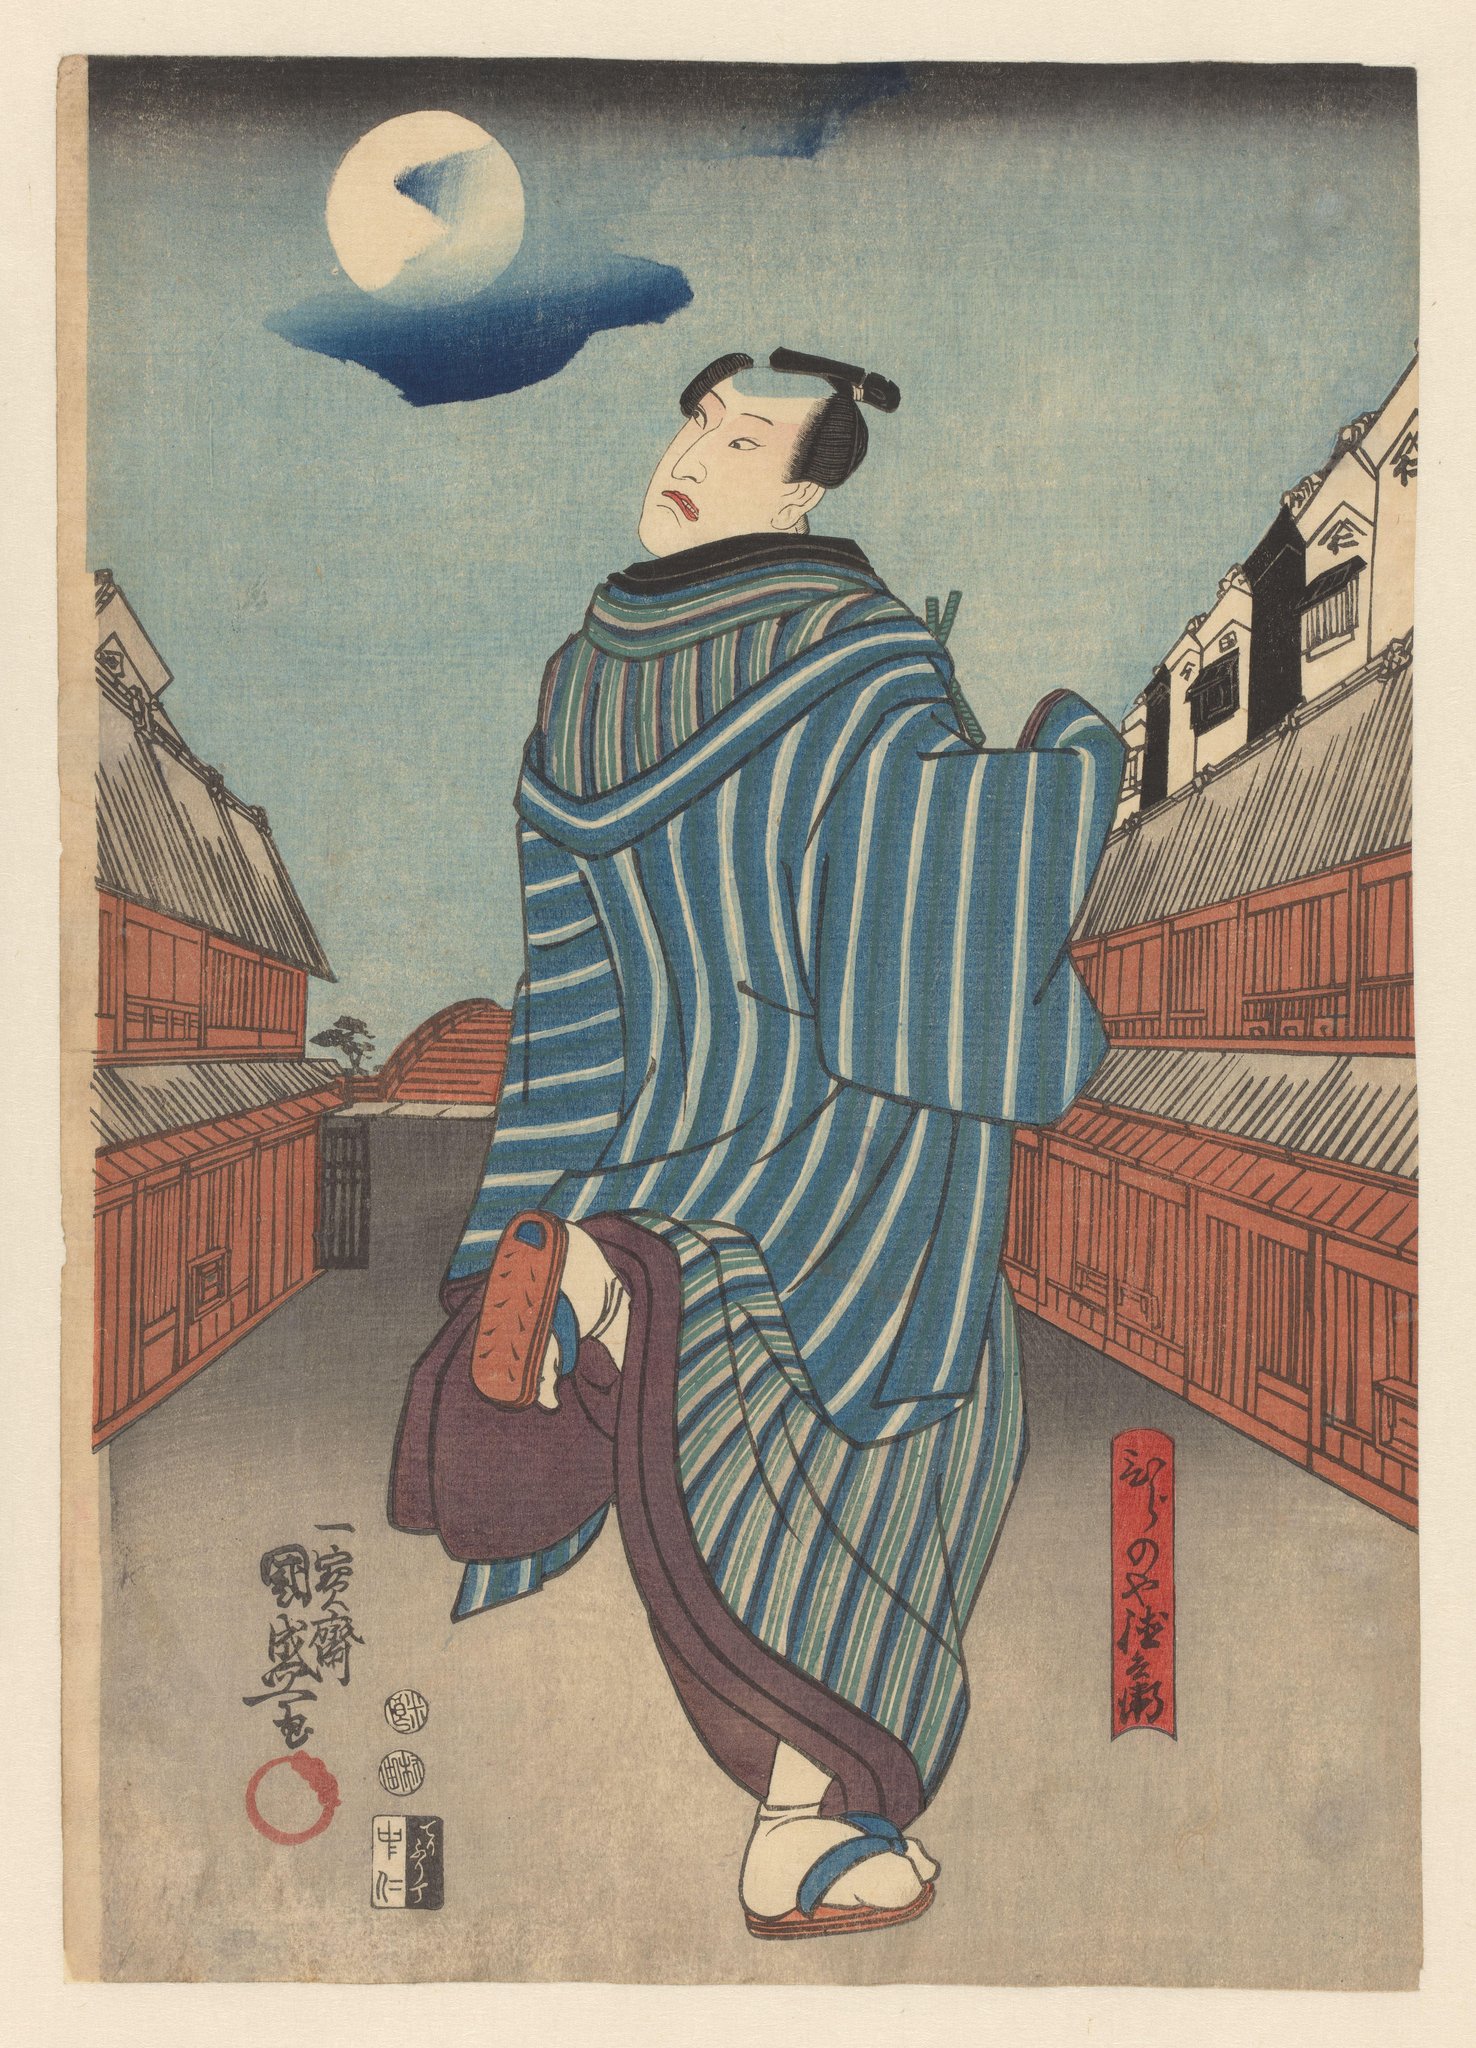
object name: print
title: Tokubei running through a street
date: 1846-1848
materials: paper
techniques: woodcut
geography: japan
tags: full moon, adult man, street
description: Tokubei in blauw gestreepte kimono, rennend bij volle maan door een straat met aan weerszijden gesloten houten warenhuizen.